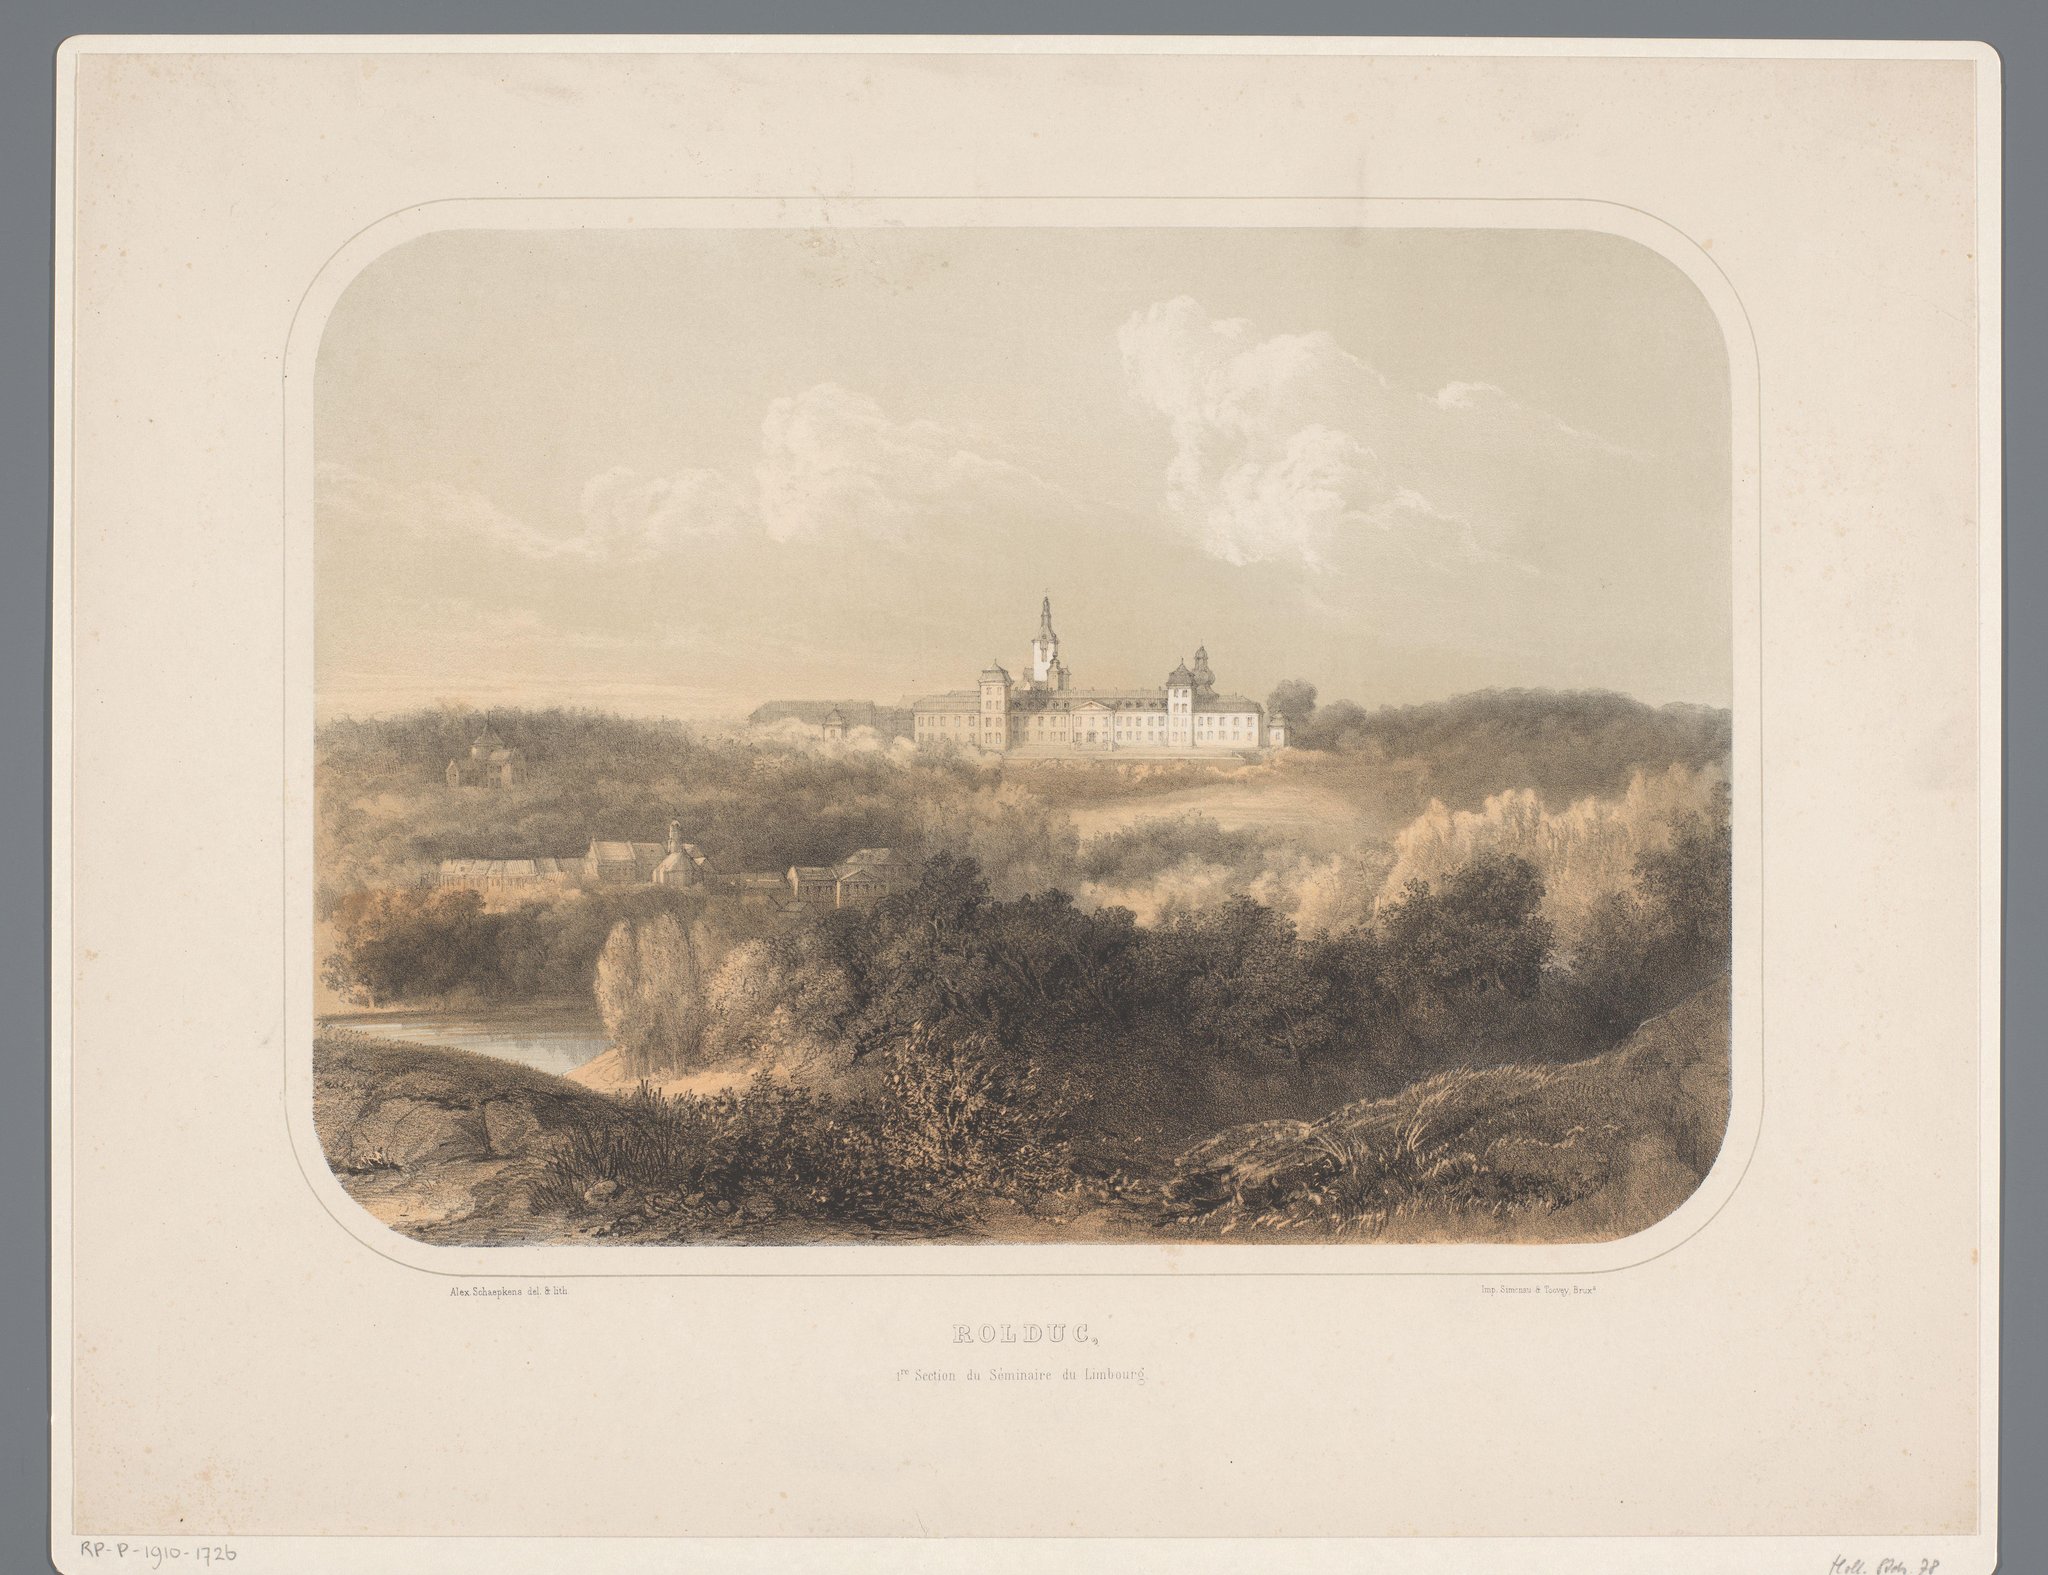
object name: print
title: Rolduc, 1re Section du Séminaire du Limbourg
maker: alexander schaepkens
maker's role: draughtsman, print maker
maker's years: 1815-1899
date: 1852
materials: paper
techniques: tone lithography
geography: brussels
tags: abbey, monastery, convent ~ roman catholic church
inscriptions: collector's mark: Lugt 2228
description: Landschap met in de achtergrond abdij Rolduc.